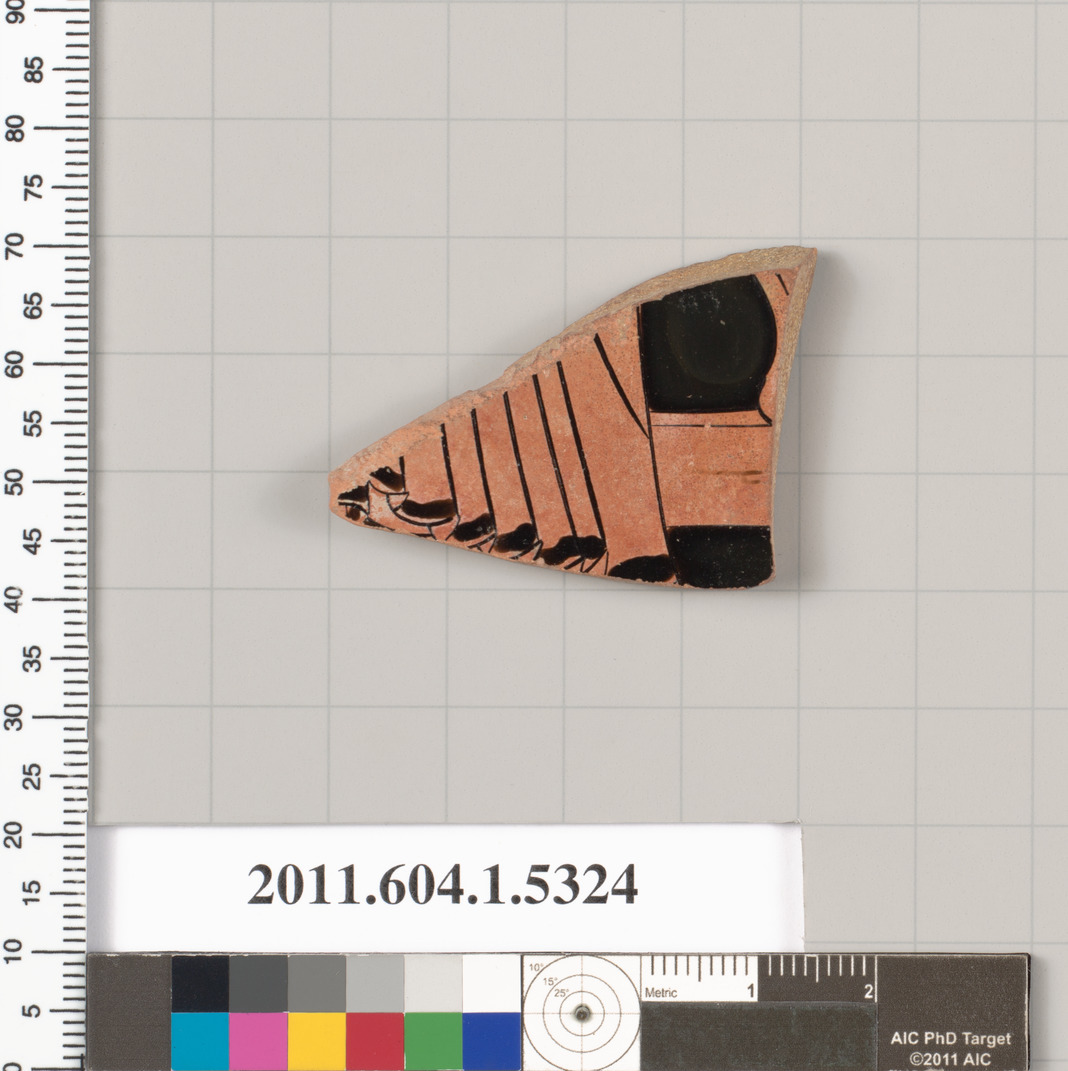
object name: kylix fragment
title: Terracotta fragment of a kylix (drinking cup)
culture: greek, attic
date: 500-480 BCE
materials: terracotta